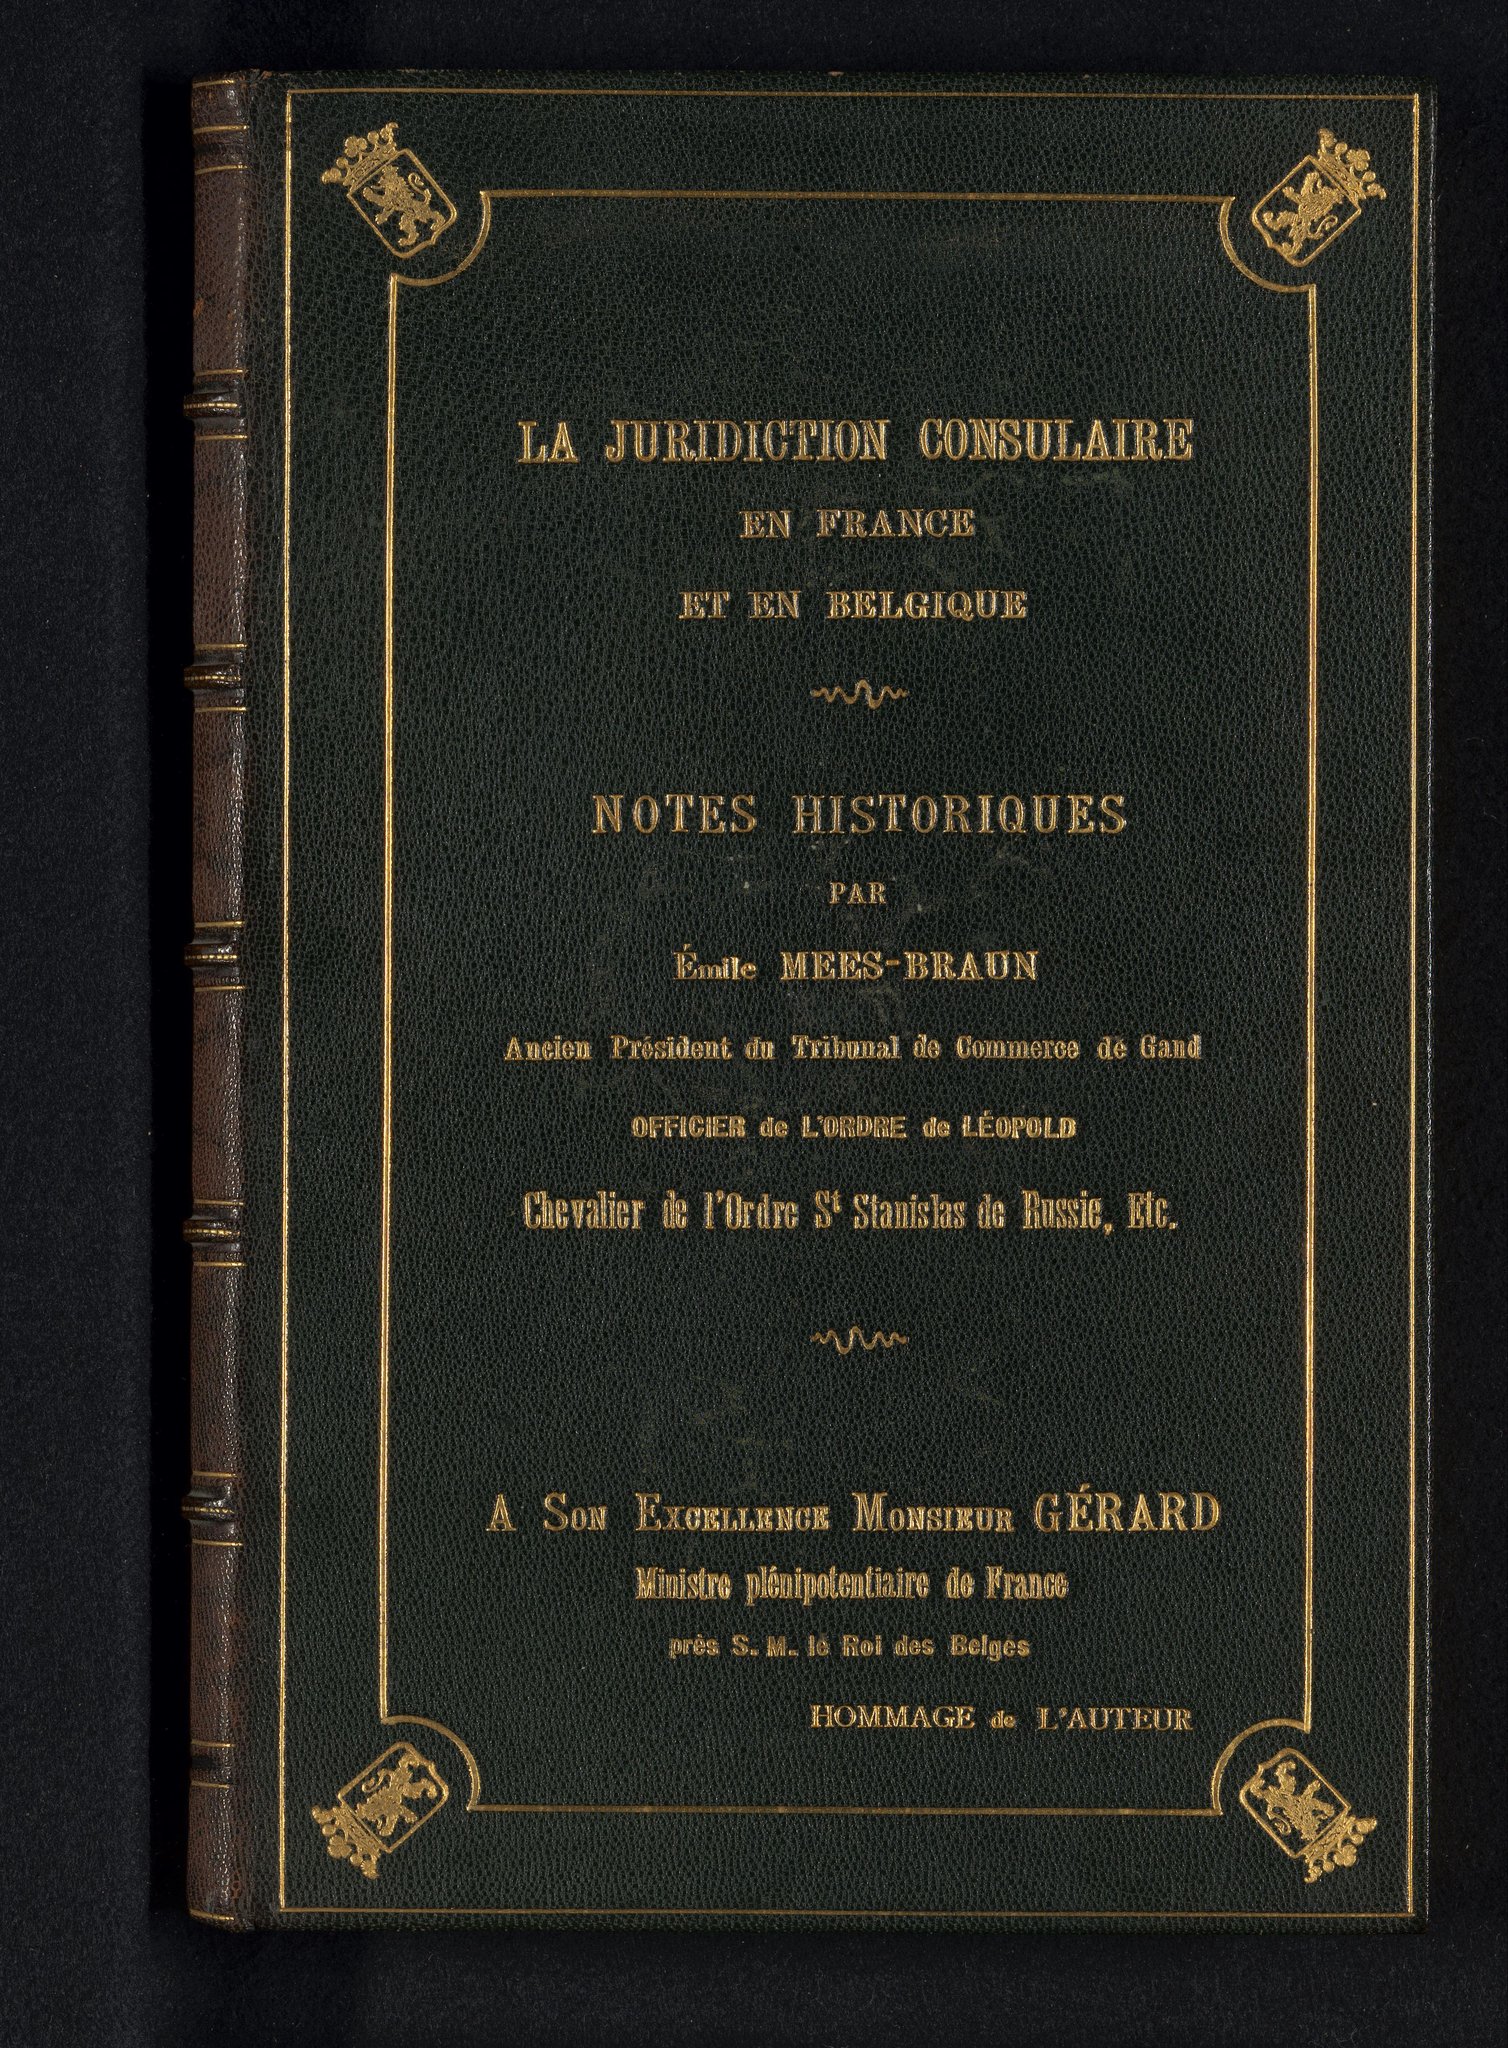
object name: book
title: La juridiction consulaire en France et en Belgique : notes historiques / par Émile Mees-Braun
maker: émile mees-braun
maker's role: auteur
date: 1899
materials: cardboard, leather, paper, photographic support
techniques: gelatin silver print, printing, marbling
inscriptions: annotation: ‘à son Excellence/ monsieur Gérard/ envoye extraordinaire et ministre plénipotentiaire/ de la République Française prés/ J.M. le Roi de Belges/ Respectueux hommage de l'auteur/ 20 Juin 1904. E. Mees-Braun’, annotation: ‘DEC/ 1995’, annotation: ‘n 196/ Liste lw. s/Bruxelles’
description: Dit boek zit samen in een band met RP-F-2001-7-1327A.